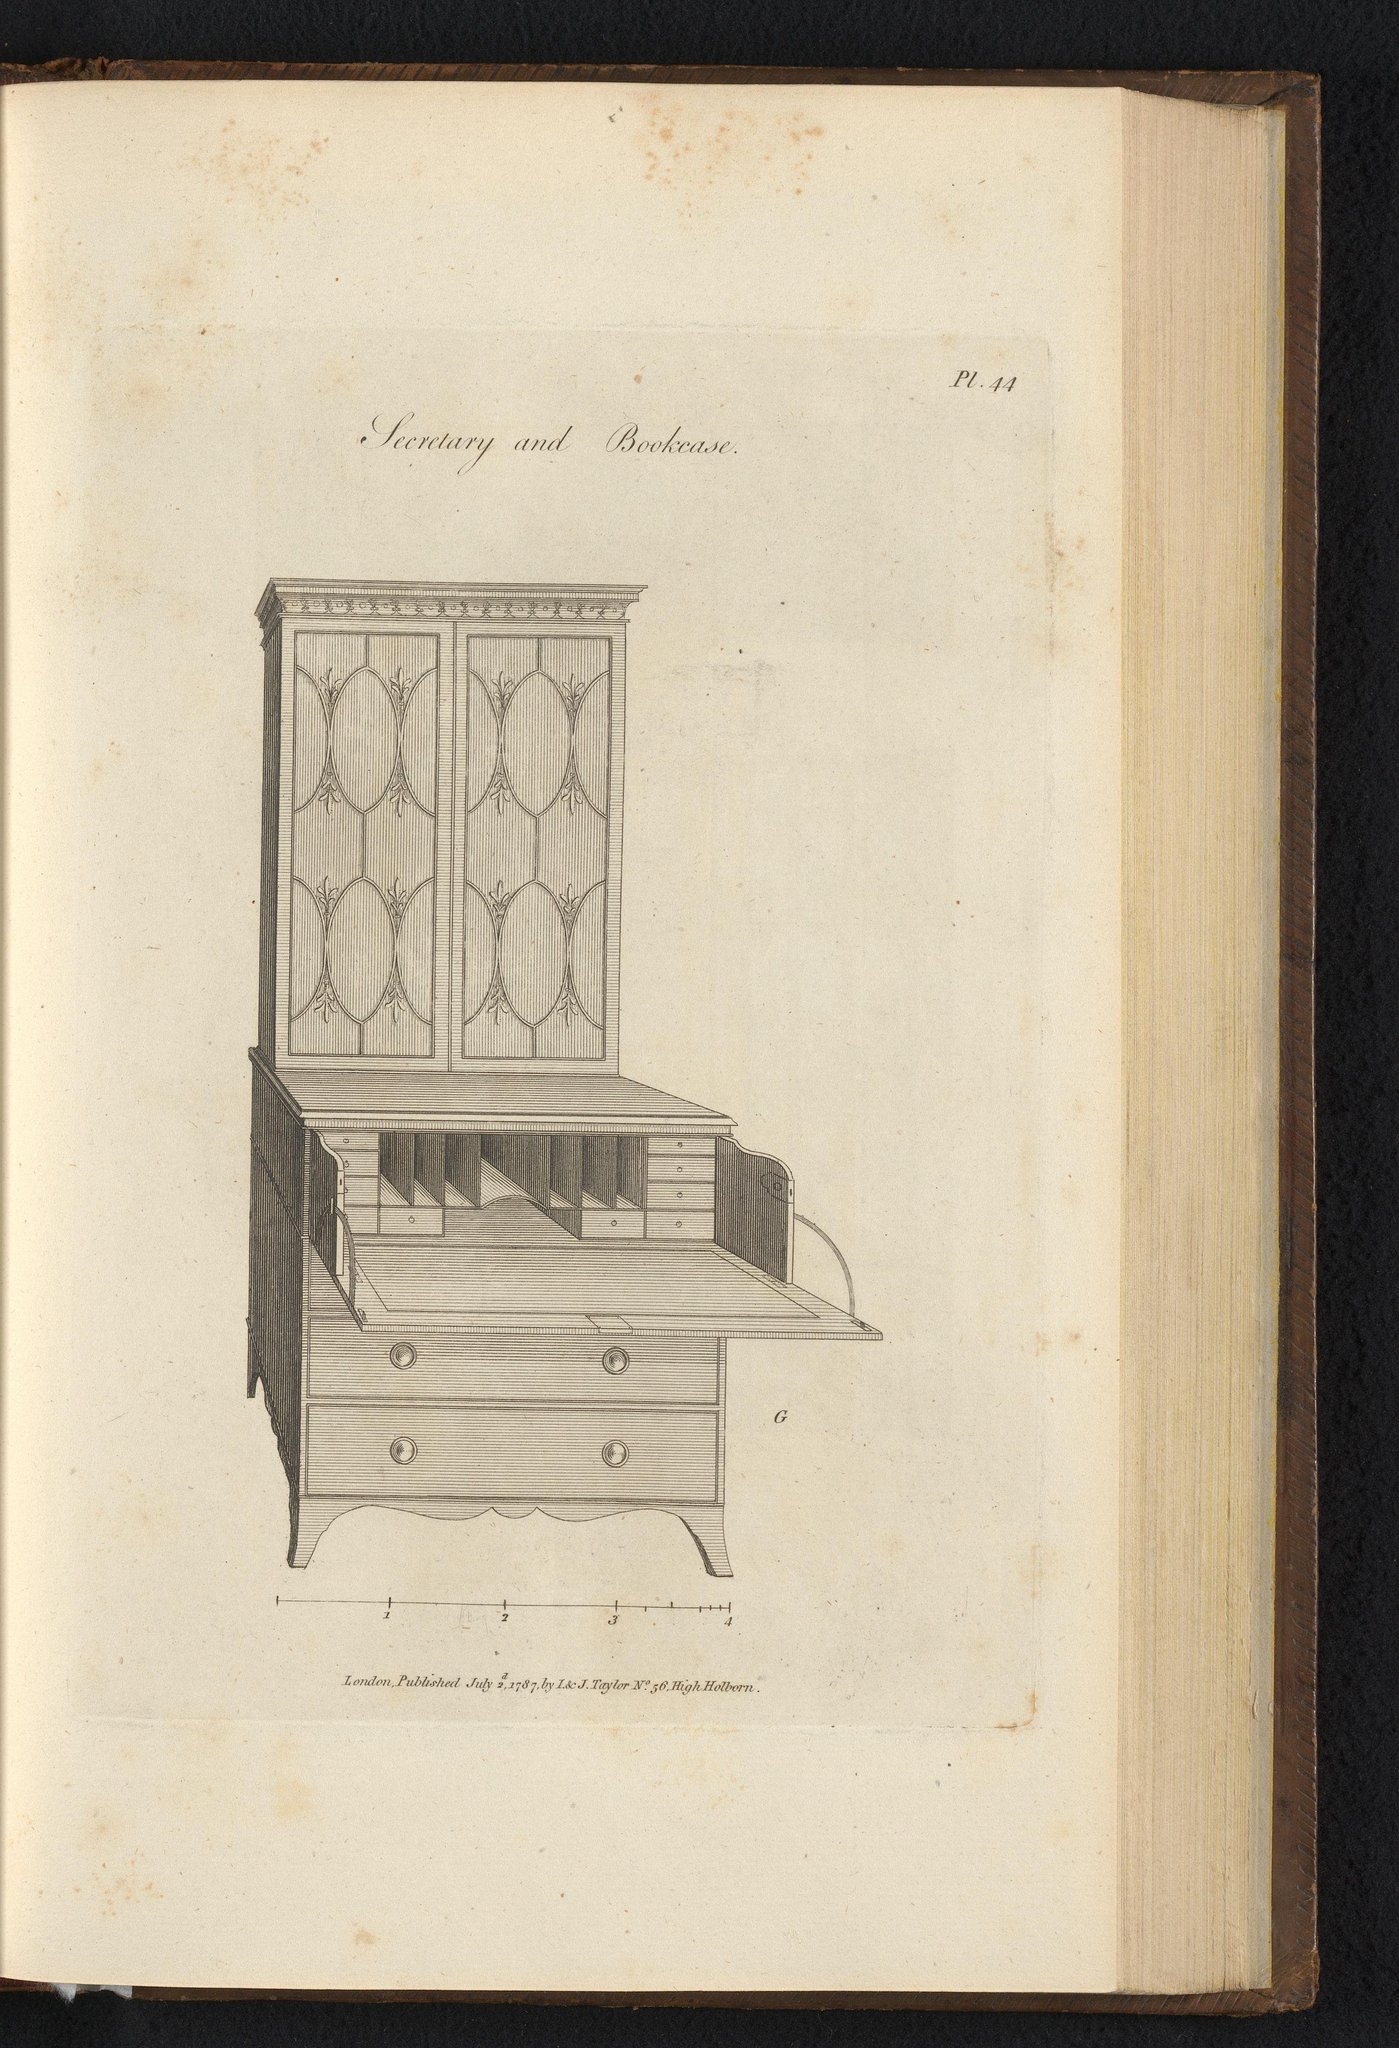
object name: page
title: Meubels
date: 1787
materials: paper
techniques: engraving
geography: holborn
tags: bookcase, with doors, table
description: Genummerd: Pl. 44. Secretaire gemerkt met: G. Schaalverdeling in de ondermarge. Prent maakt deel uit van een boek.